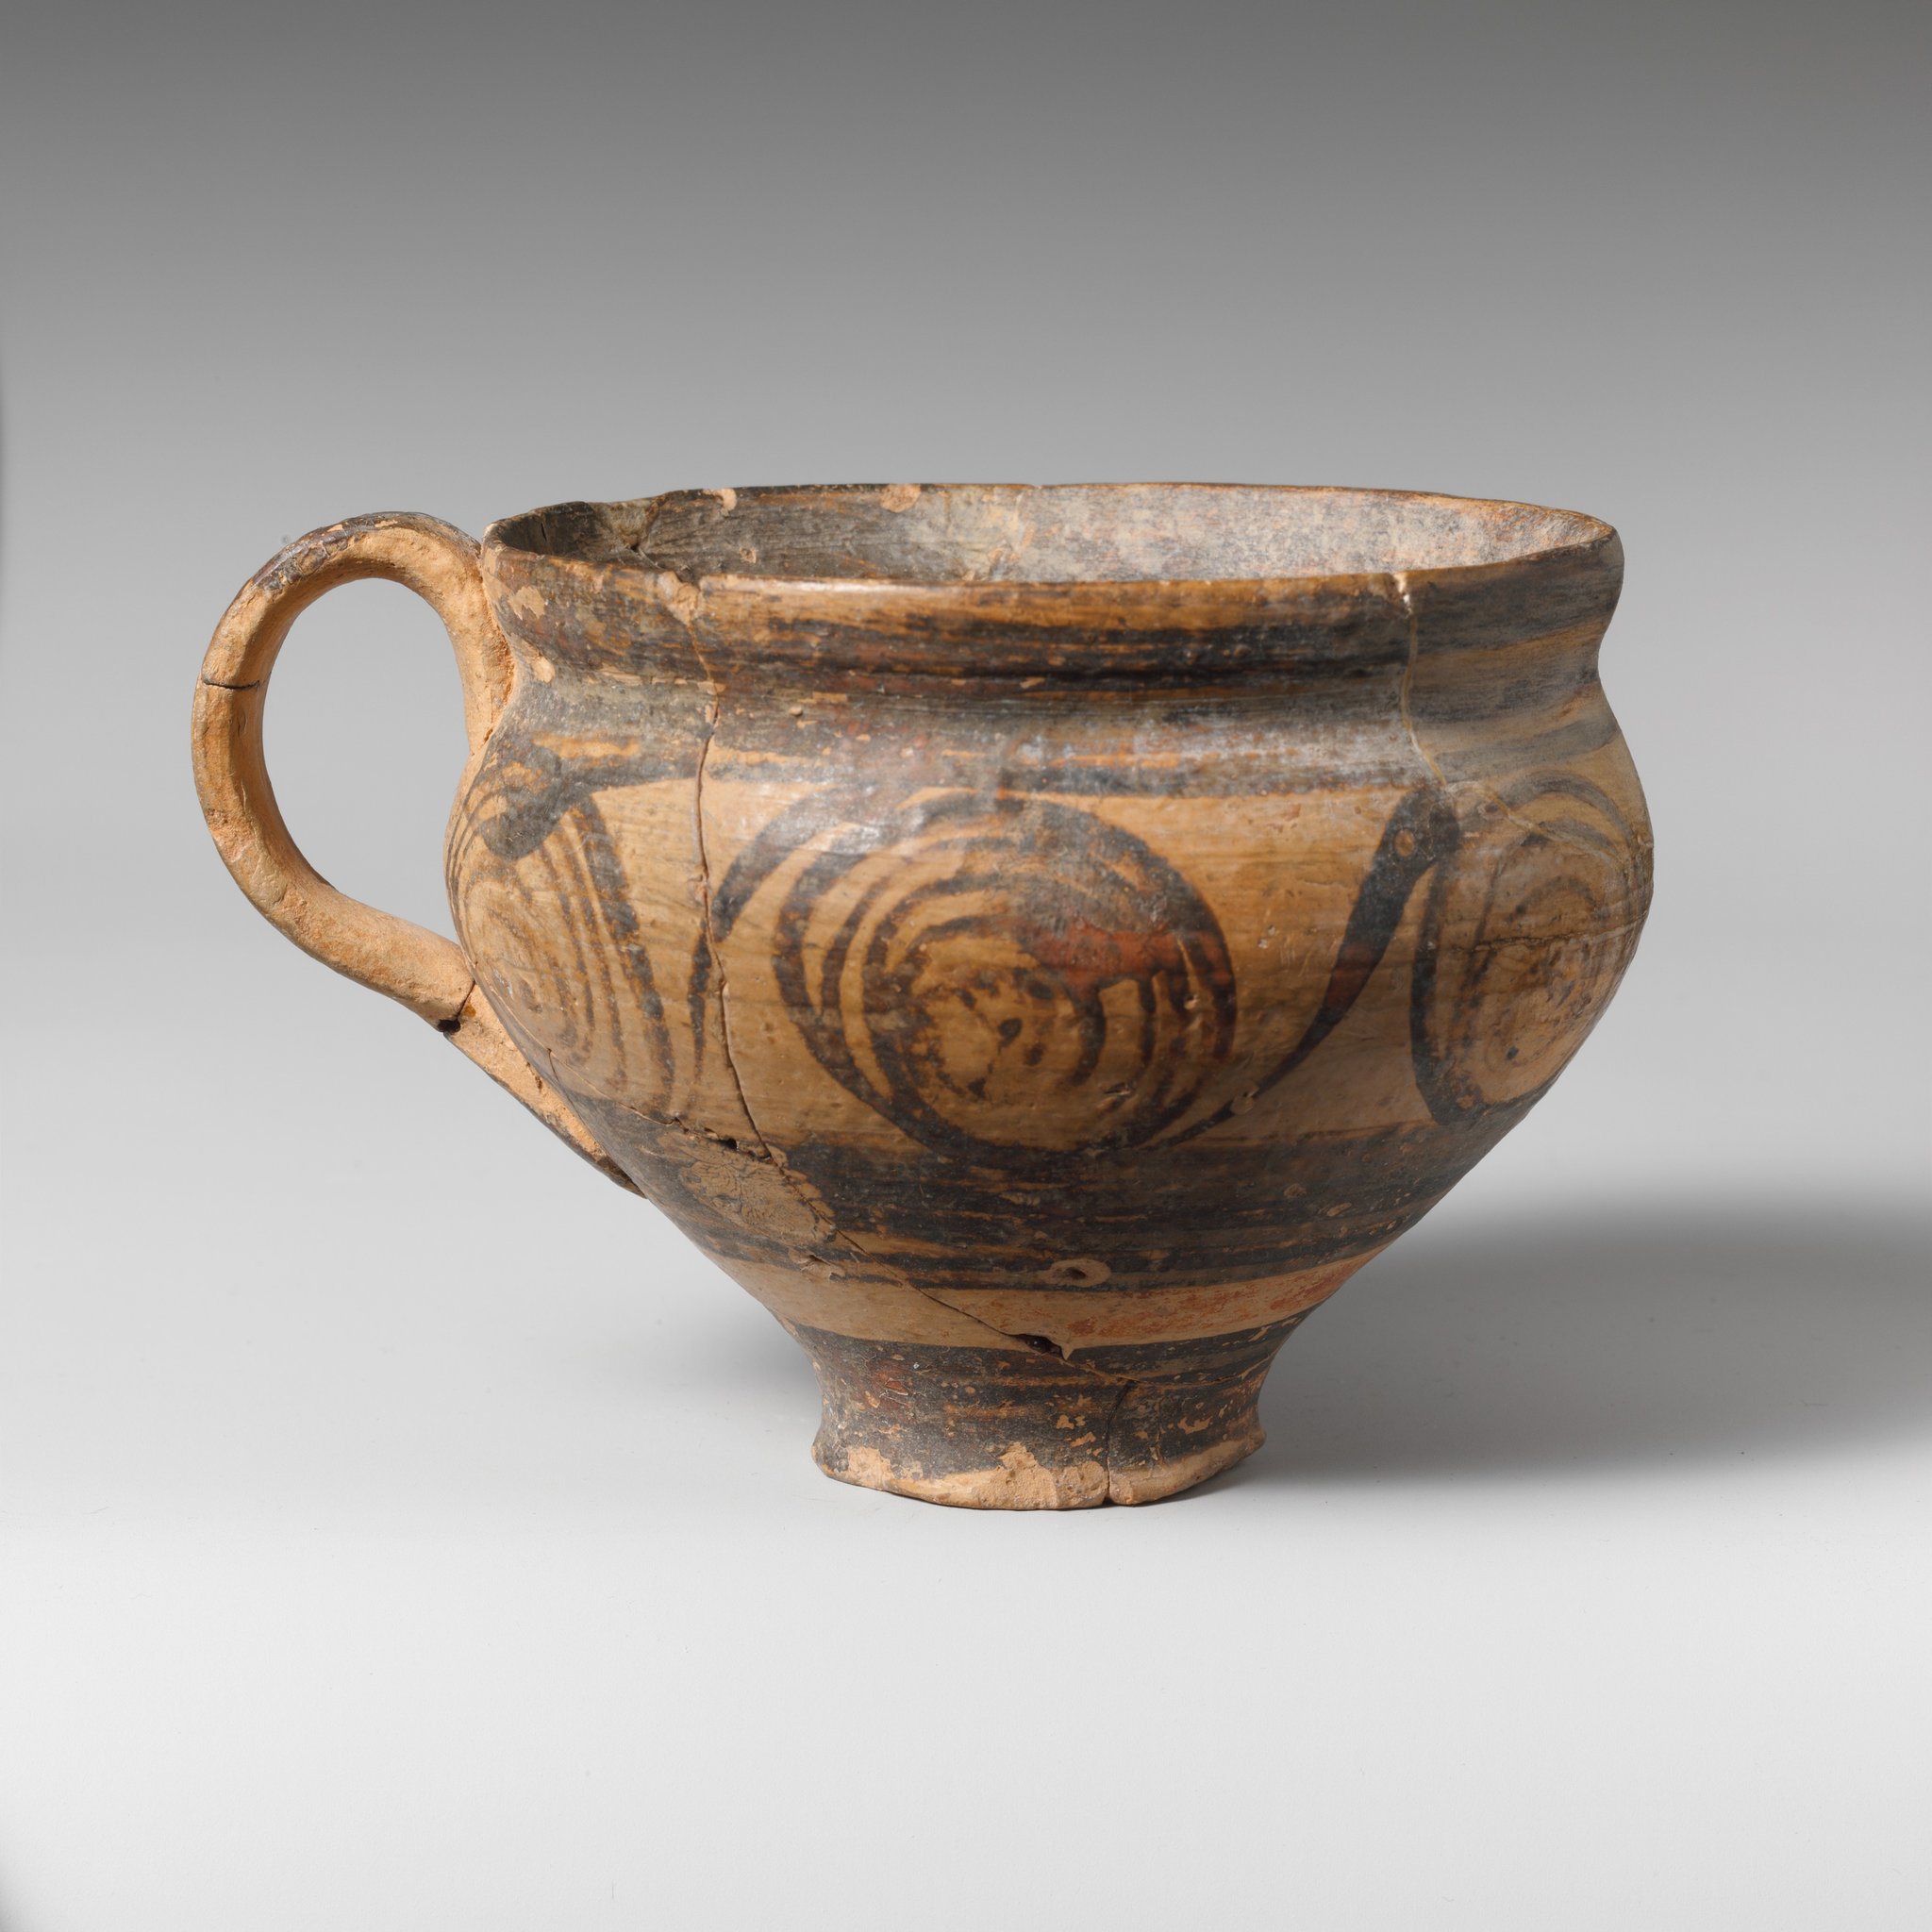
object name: cup, one handled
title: Terracotta hemispherical cup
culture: minoan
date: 1600-1450 BCE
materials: terracotta